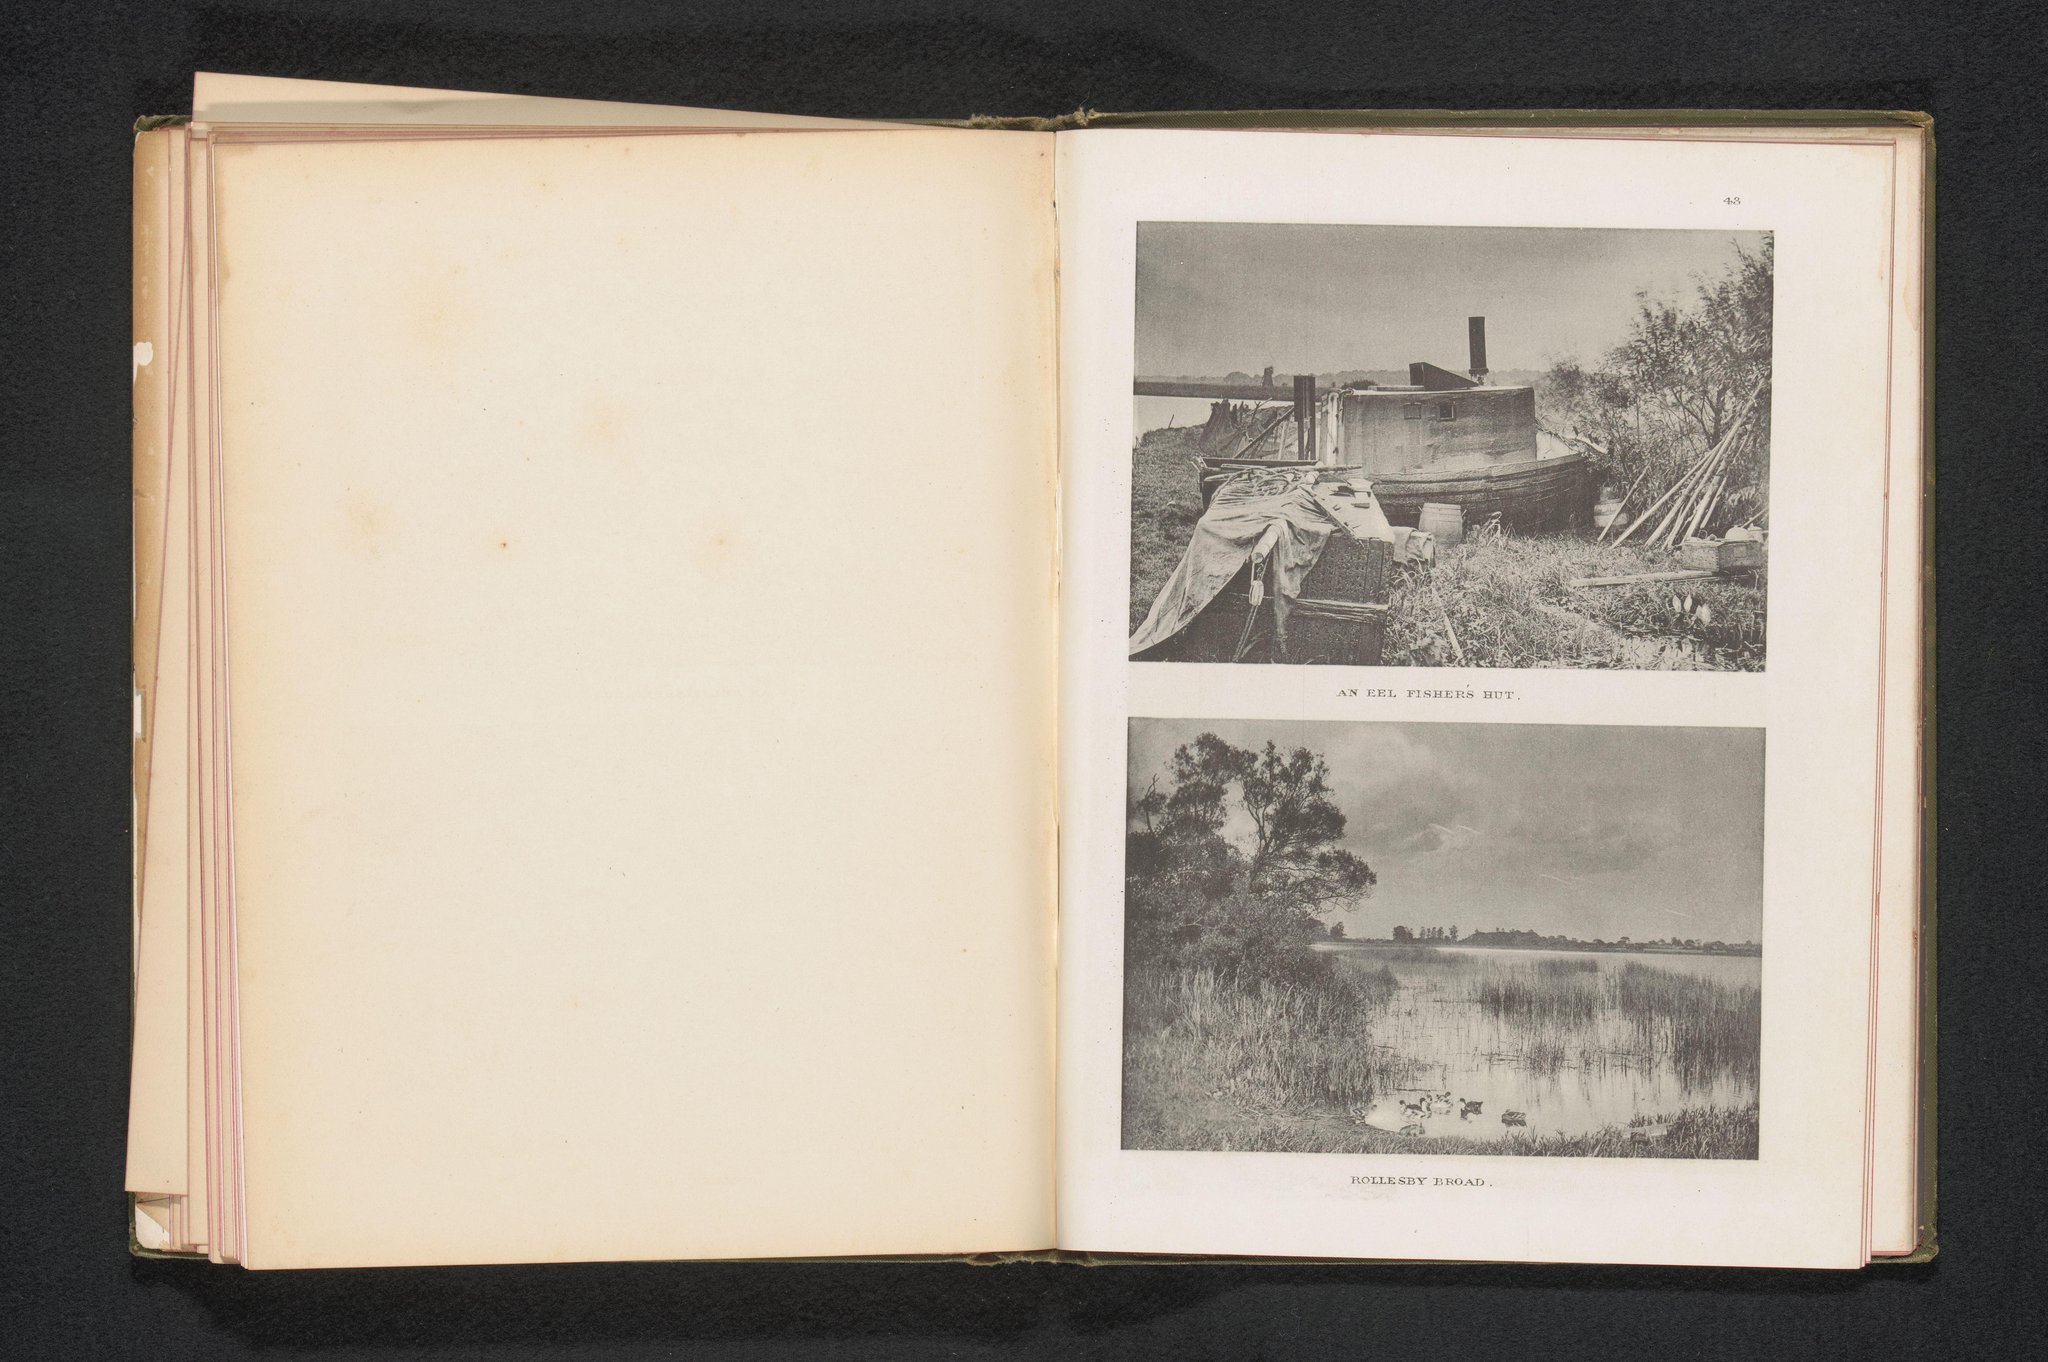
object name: photomechanical print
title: Rollesby Broad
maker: john payne jennings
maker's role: fotograaf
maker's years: 1843-1926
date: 1886-1891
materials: paper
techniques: photograph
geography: surrey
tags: landscapes with waters, waterscapes, seascapes (in the temperate zone), lake